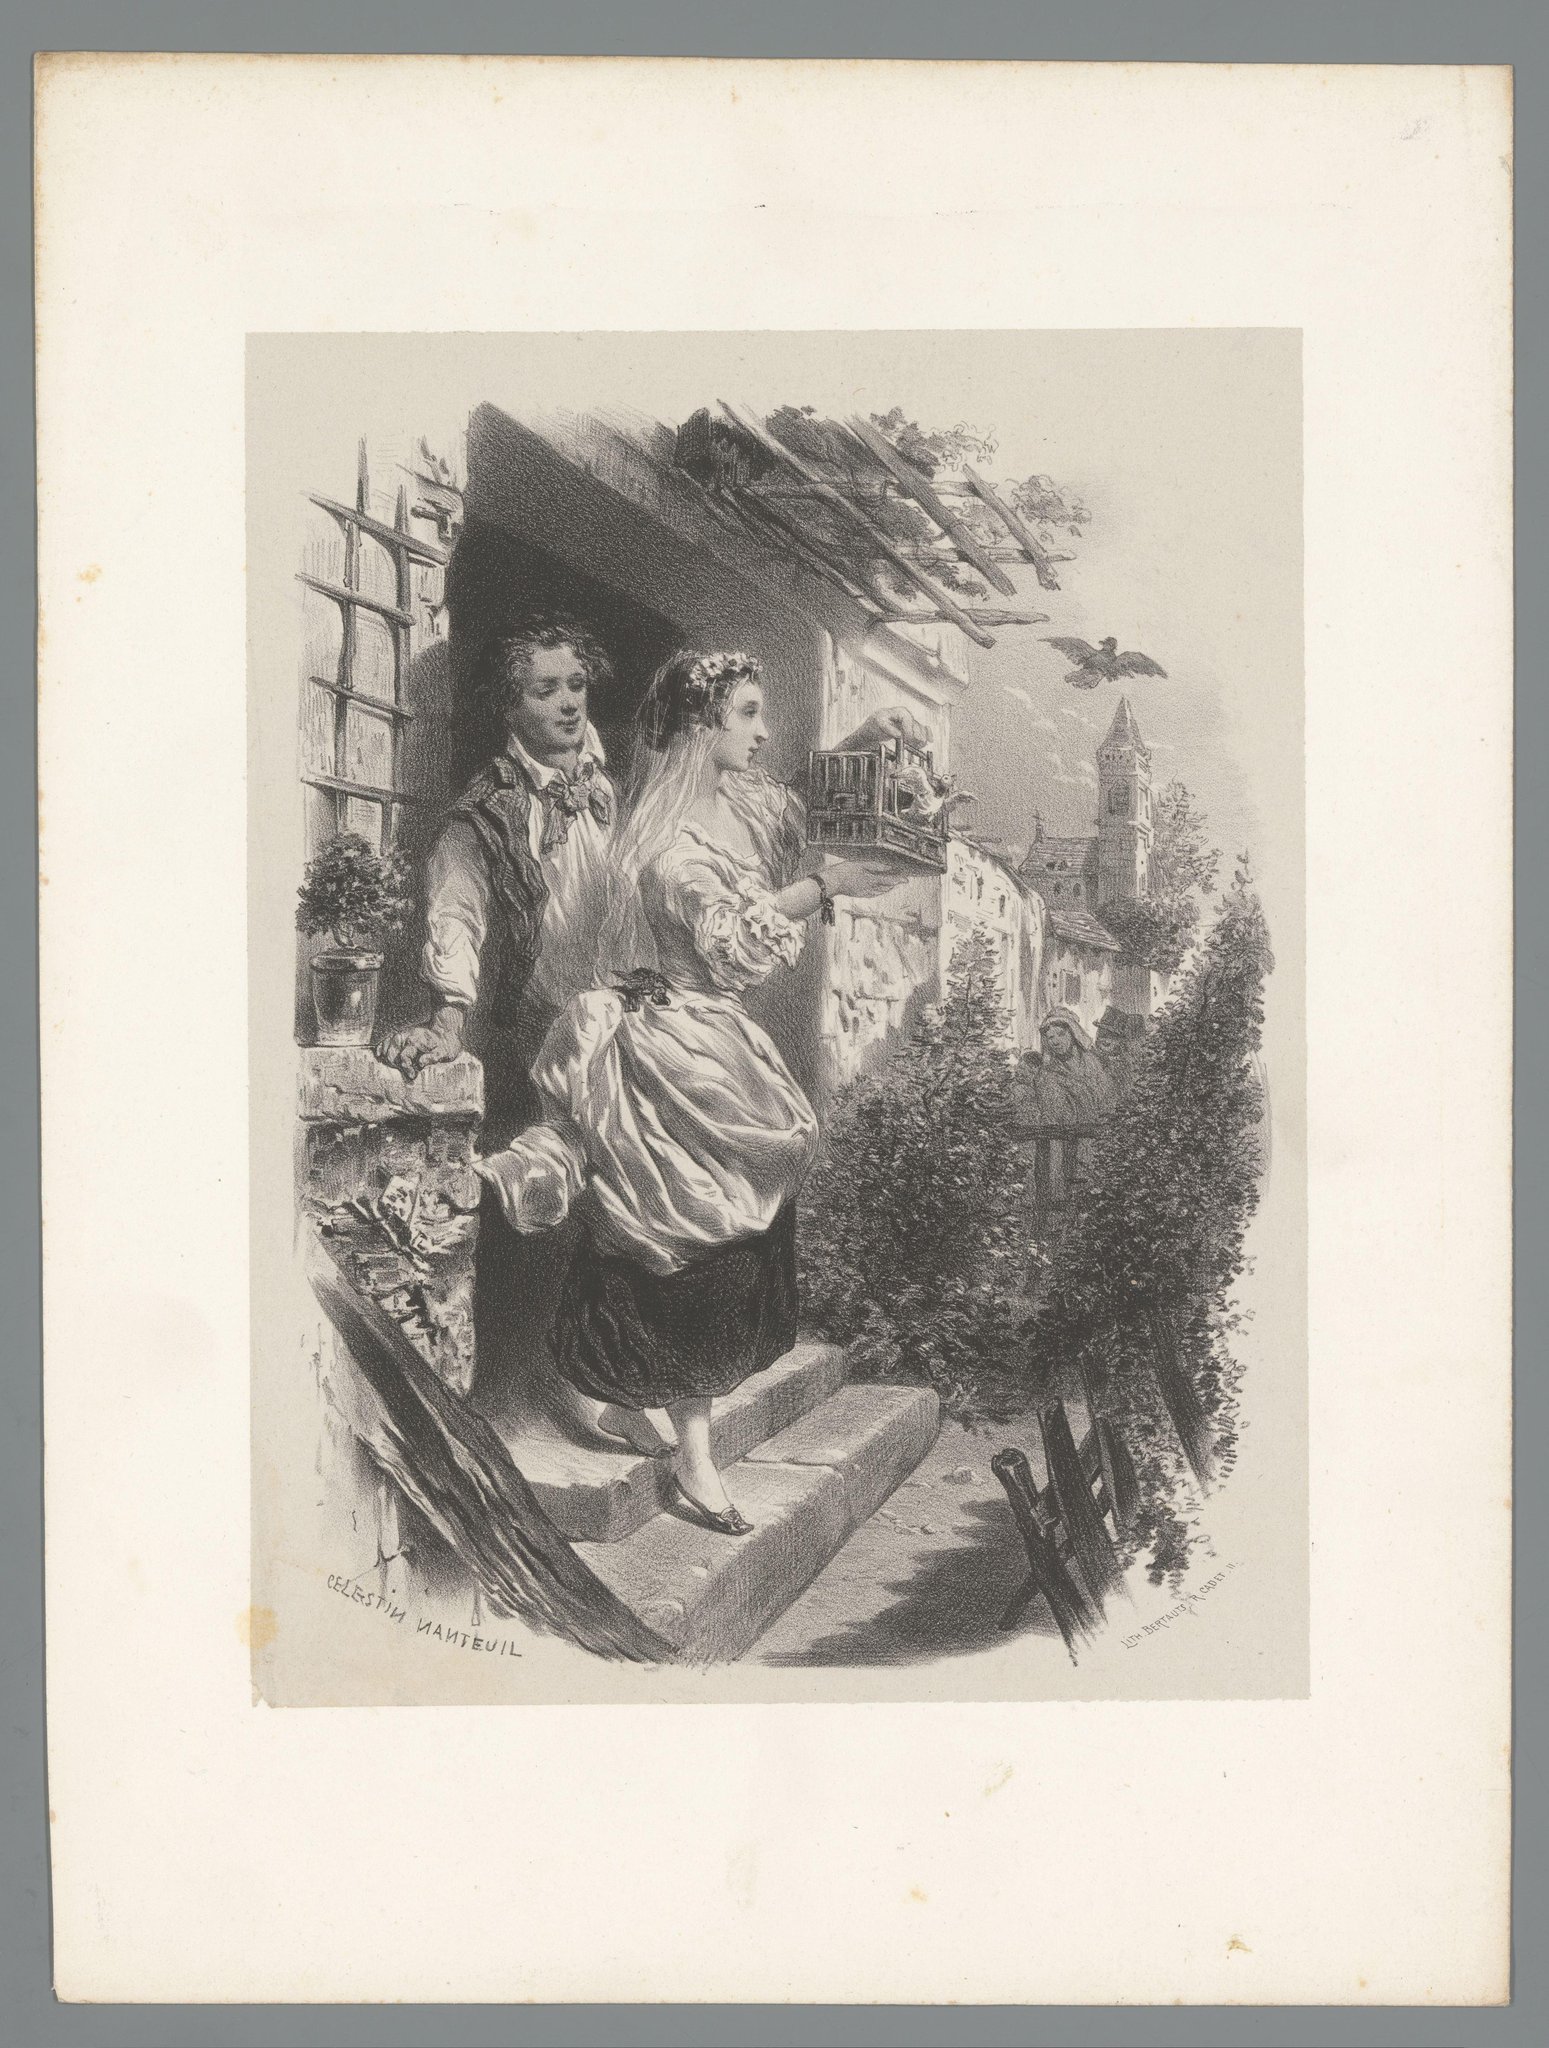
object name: print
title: Bruid laat twee duiven los uit een kooi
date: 1851-1865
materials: paper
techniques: lithograph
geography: paris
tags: bride and groom in wedding-dress, bird-cage opened (loss of virginity symbolized), doves, pigeons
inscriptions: collector's mark: Lugt 964